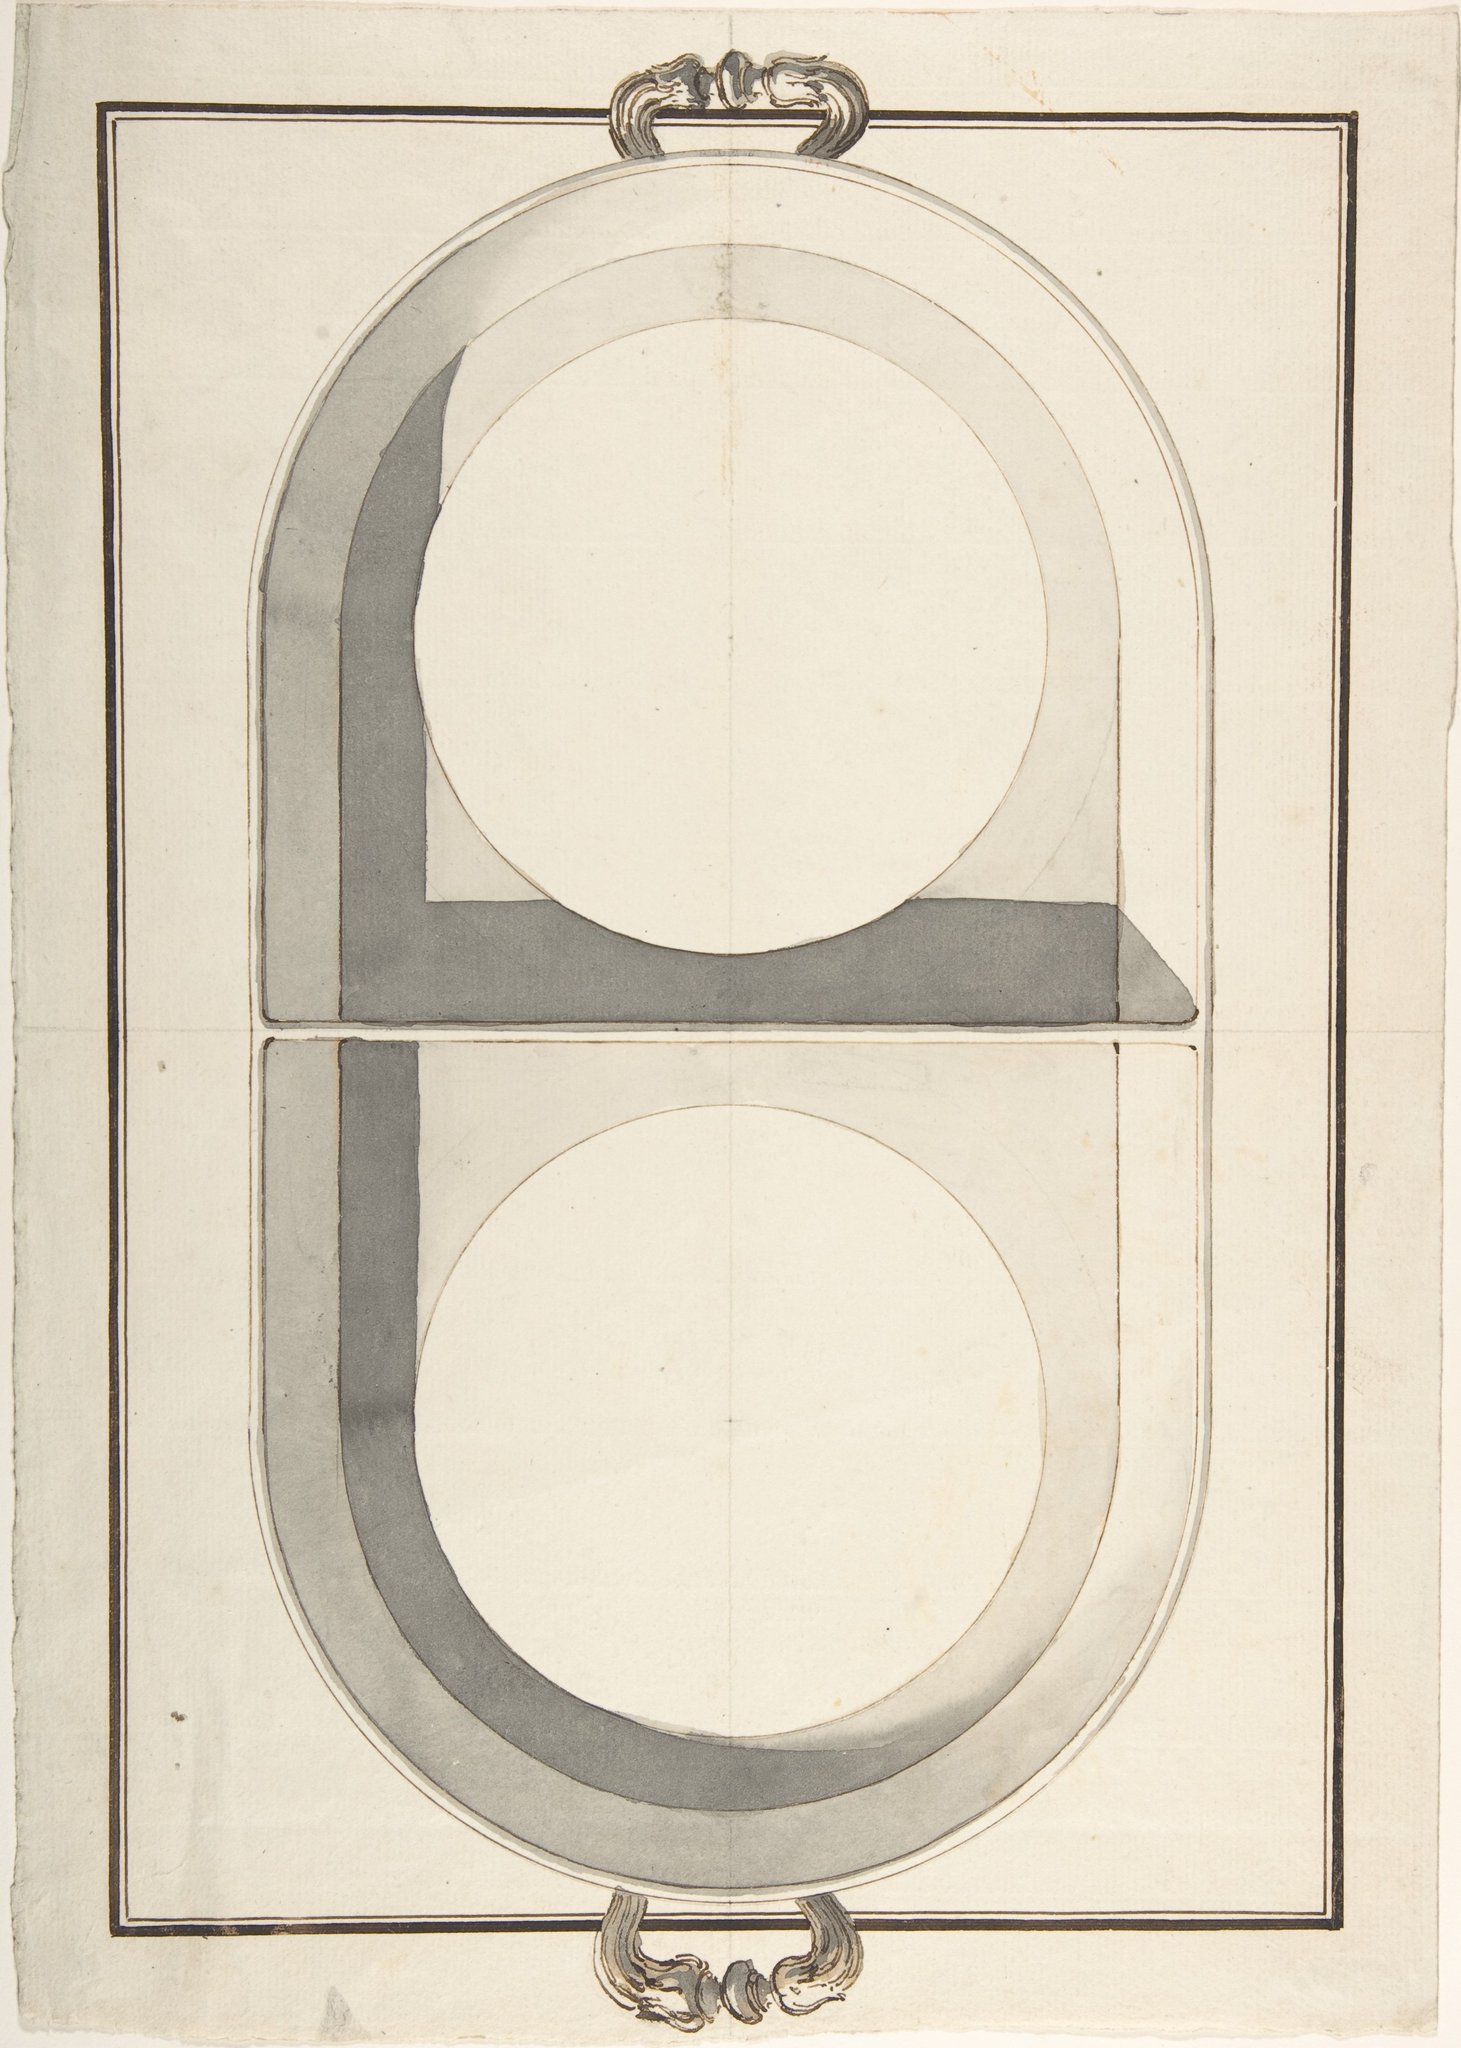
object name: drawing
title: Oblong Vegetable Dish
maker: anonymous, italian, 19th century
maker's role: artist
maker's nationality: italian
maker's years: 1800-1900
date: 1800-1900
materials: ink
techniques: pen, wash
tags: dishes